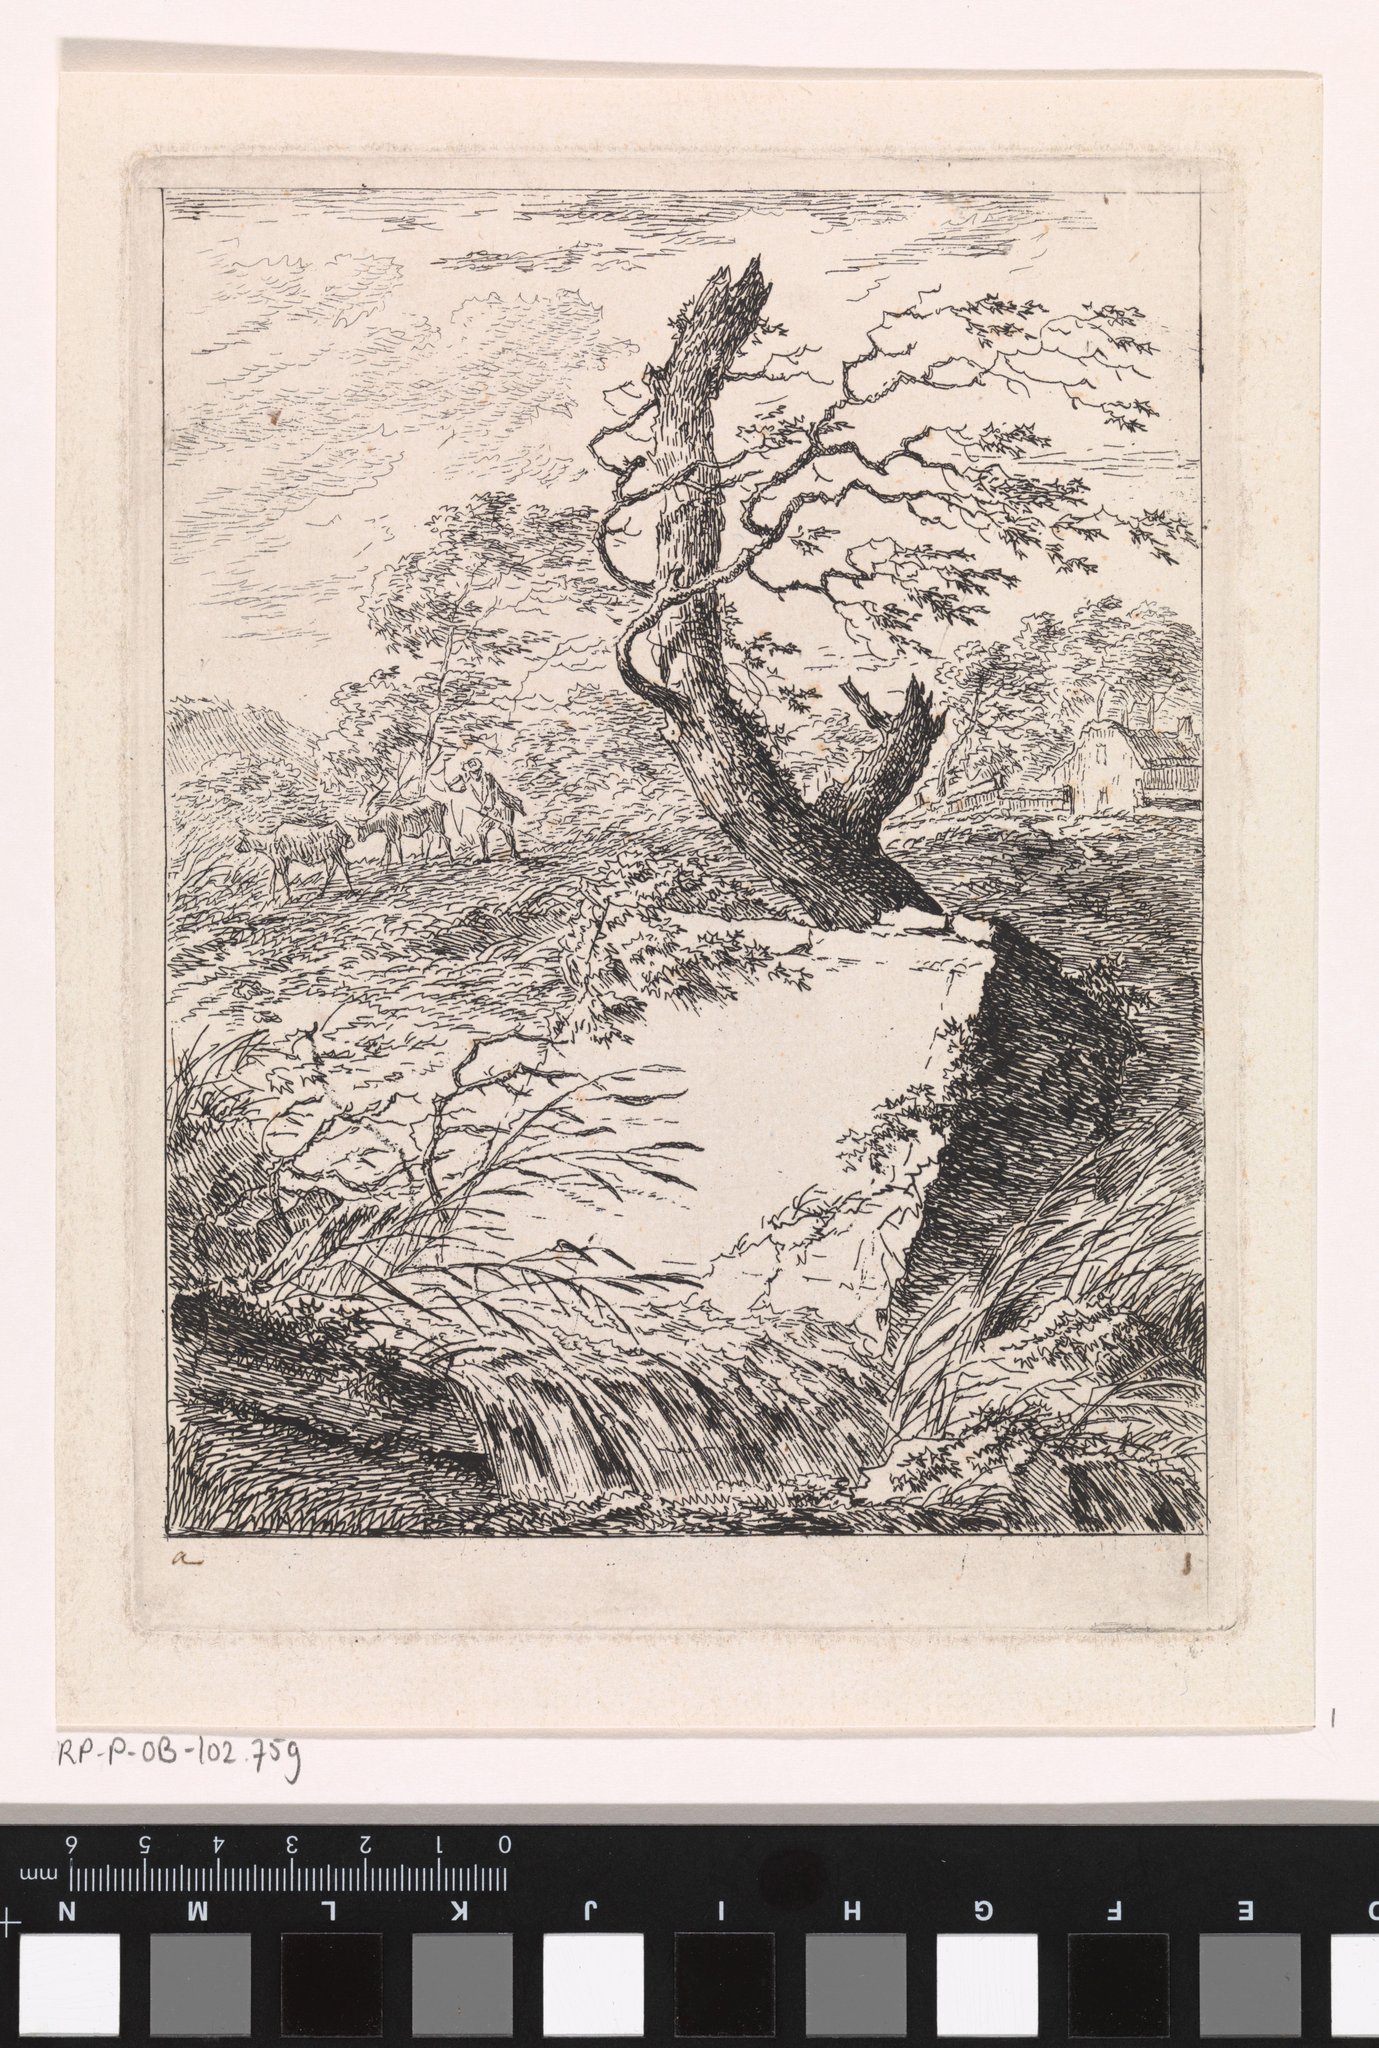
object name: titelprent, frontispice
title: Landschappen (serie A)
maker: gerard van nijmegen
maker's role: draughtsman, painter, print maker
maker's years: 1735-1808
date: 1790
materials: paper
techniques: etching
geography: rotterdam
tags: trees, cow, boulder, stone, farm or solitary house in landscape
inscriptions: inscription: ‘a / 1’, collector's mark: Lugt 2228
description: Een vierkante steen ligt onder een boom. Op de achtergrond in het landschap staat een boer met twee koeien. Rechts ligt een boerderij.